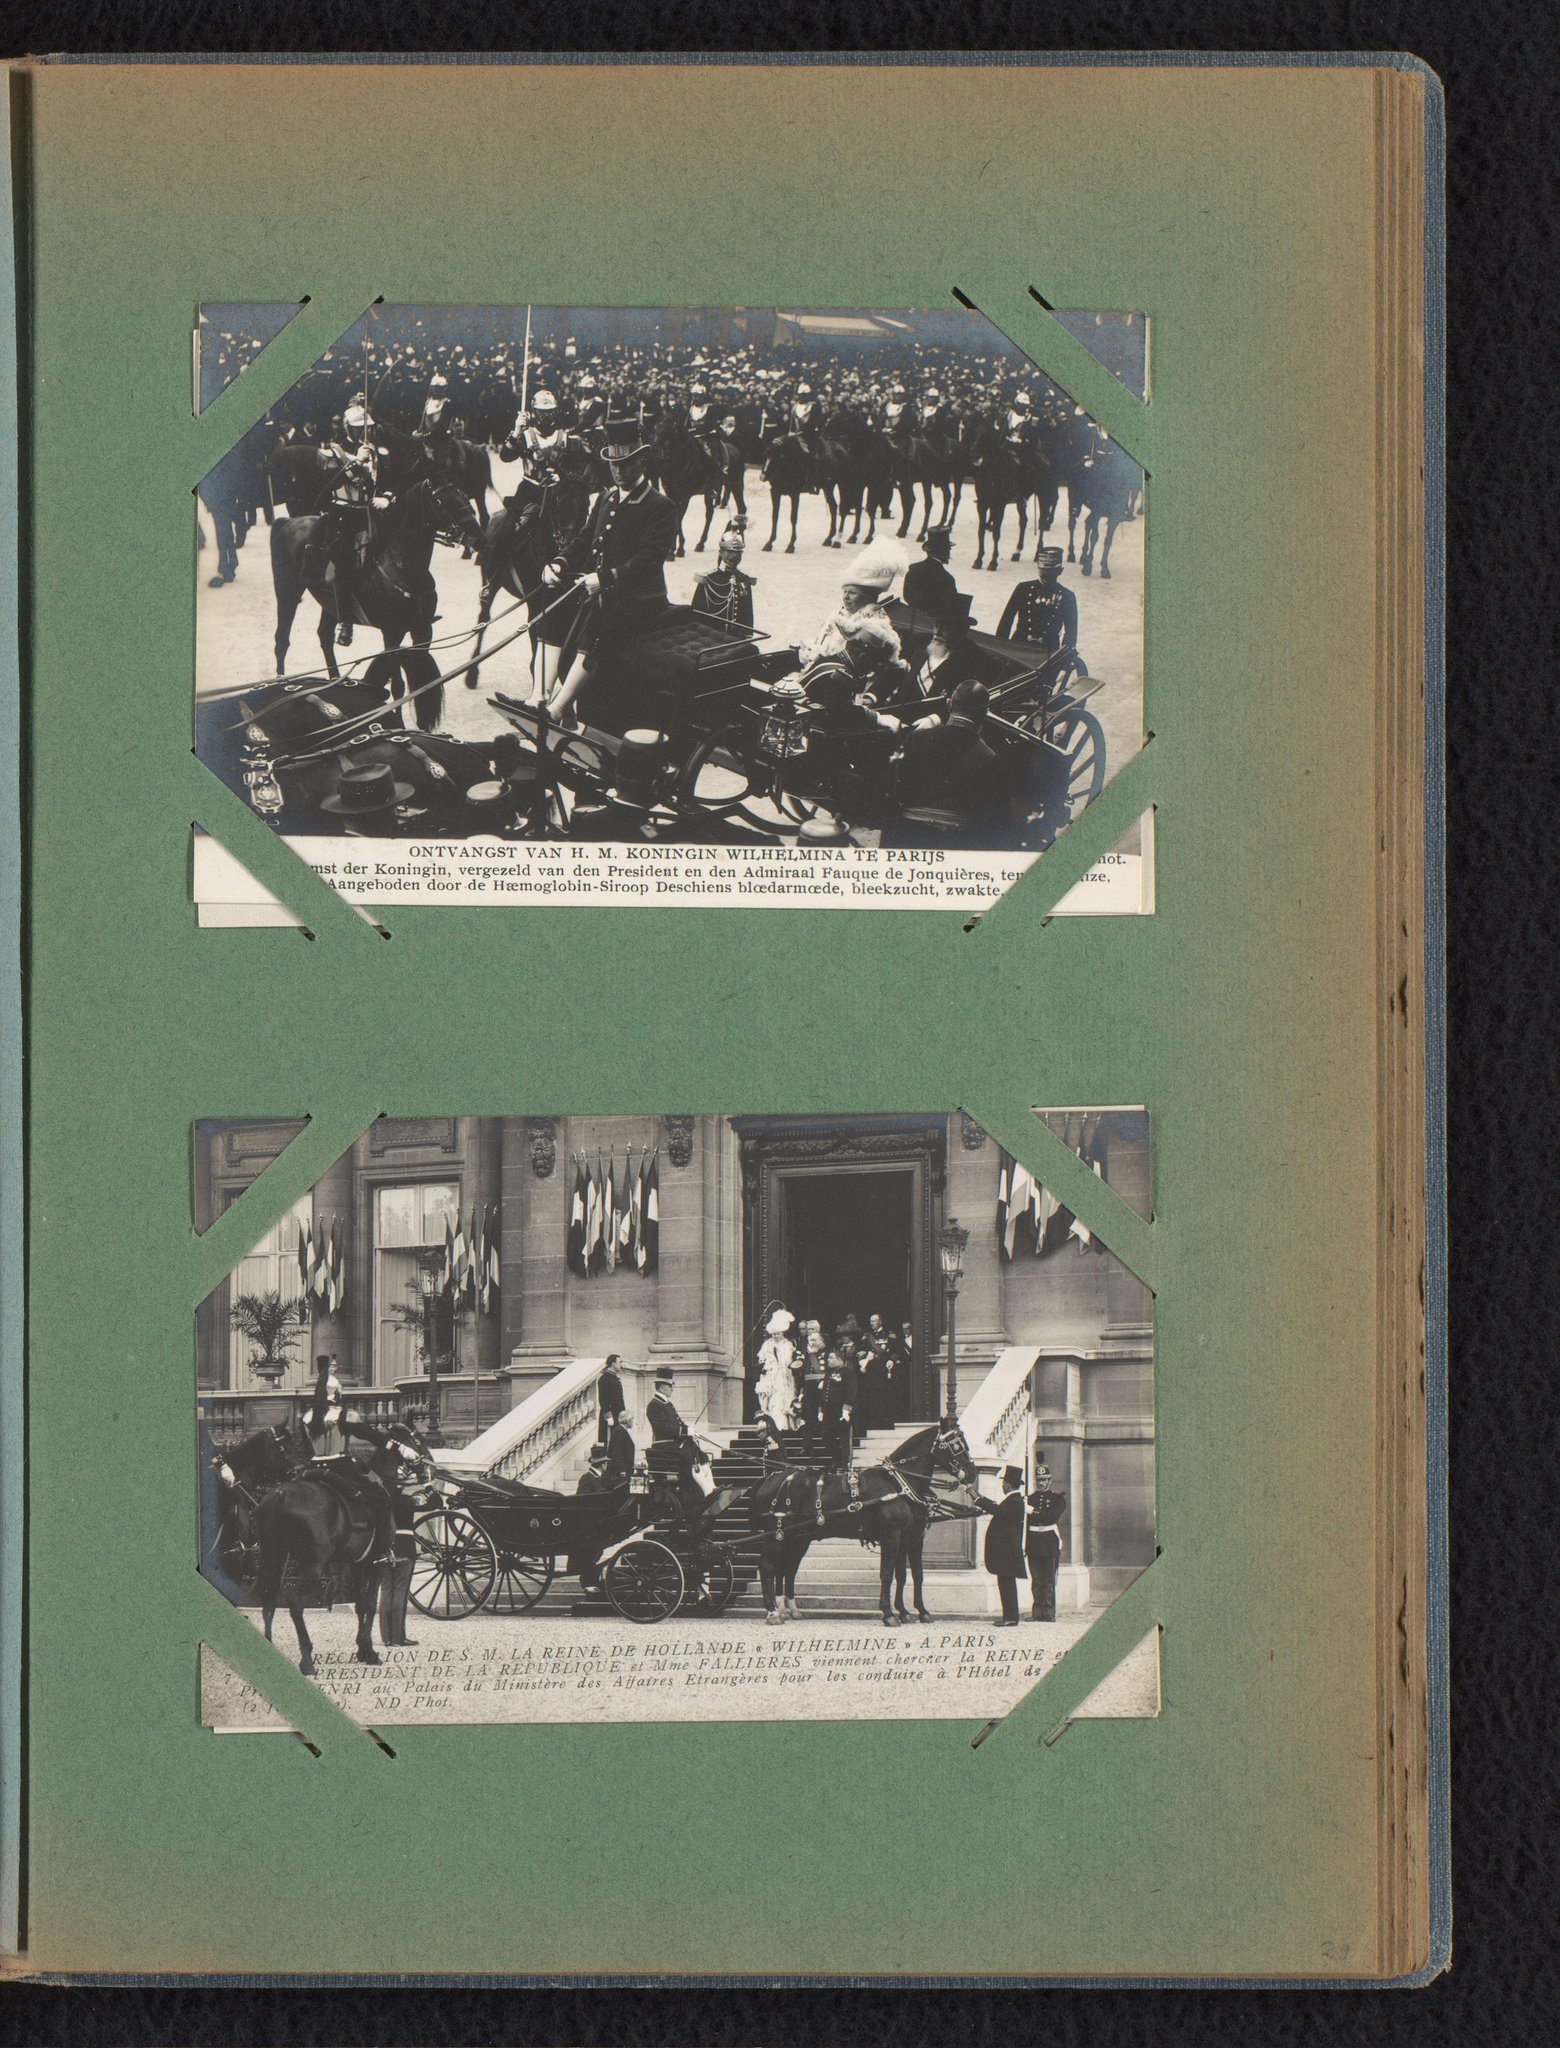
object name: ansichtkaart, prentbriefkaart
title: Twee prentbriefkaarten van het bezoek van koningin Wilhelmina aan Parijs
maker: Anonymous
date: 1912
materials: paper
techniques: gelatin silver print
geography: paris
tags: the hague, print maker, wilhelmina of the netherlands, hendrik (prins der nederlanden (1876-1934)), president ~ head of republic, queen, four-wheeled vehicle drawn by two animals, paris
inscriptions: inscription: ‘Ontvangst van H.M. Koningin Wilhelmina te Parijs/ De aankomst (...) zwakte, enz.’, inscription: ‘Reception de S.M. la Reine de Hollande "Wilhelmine" à Paris (...) N.D. Phot.’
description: Deze foto's maken deel uit van een album.